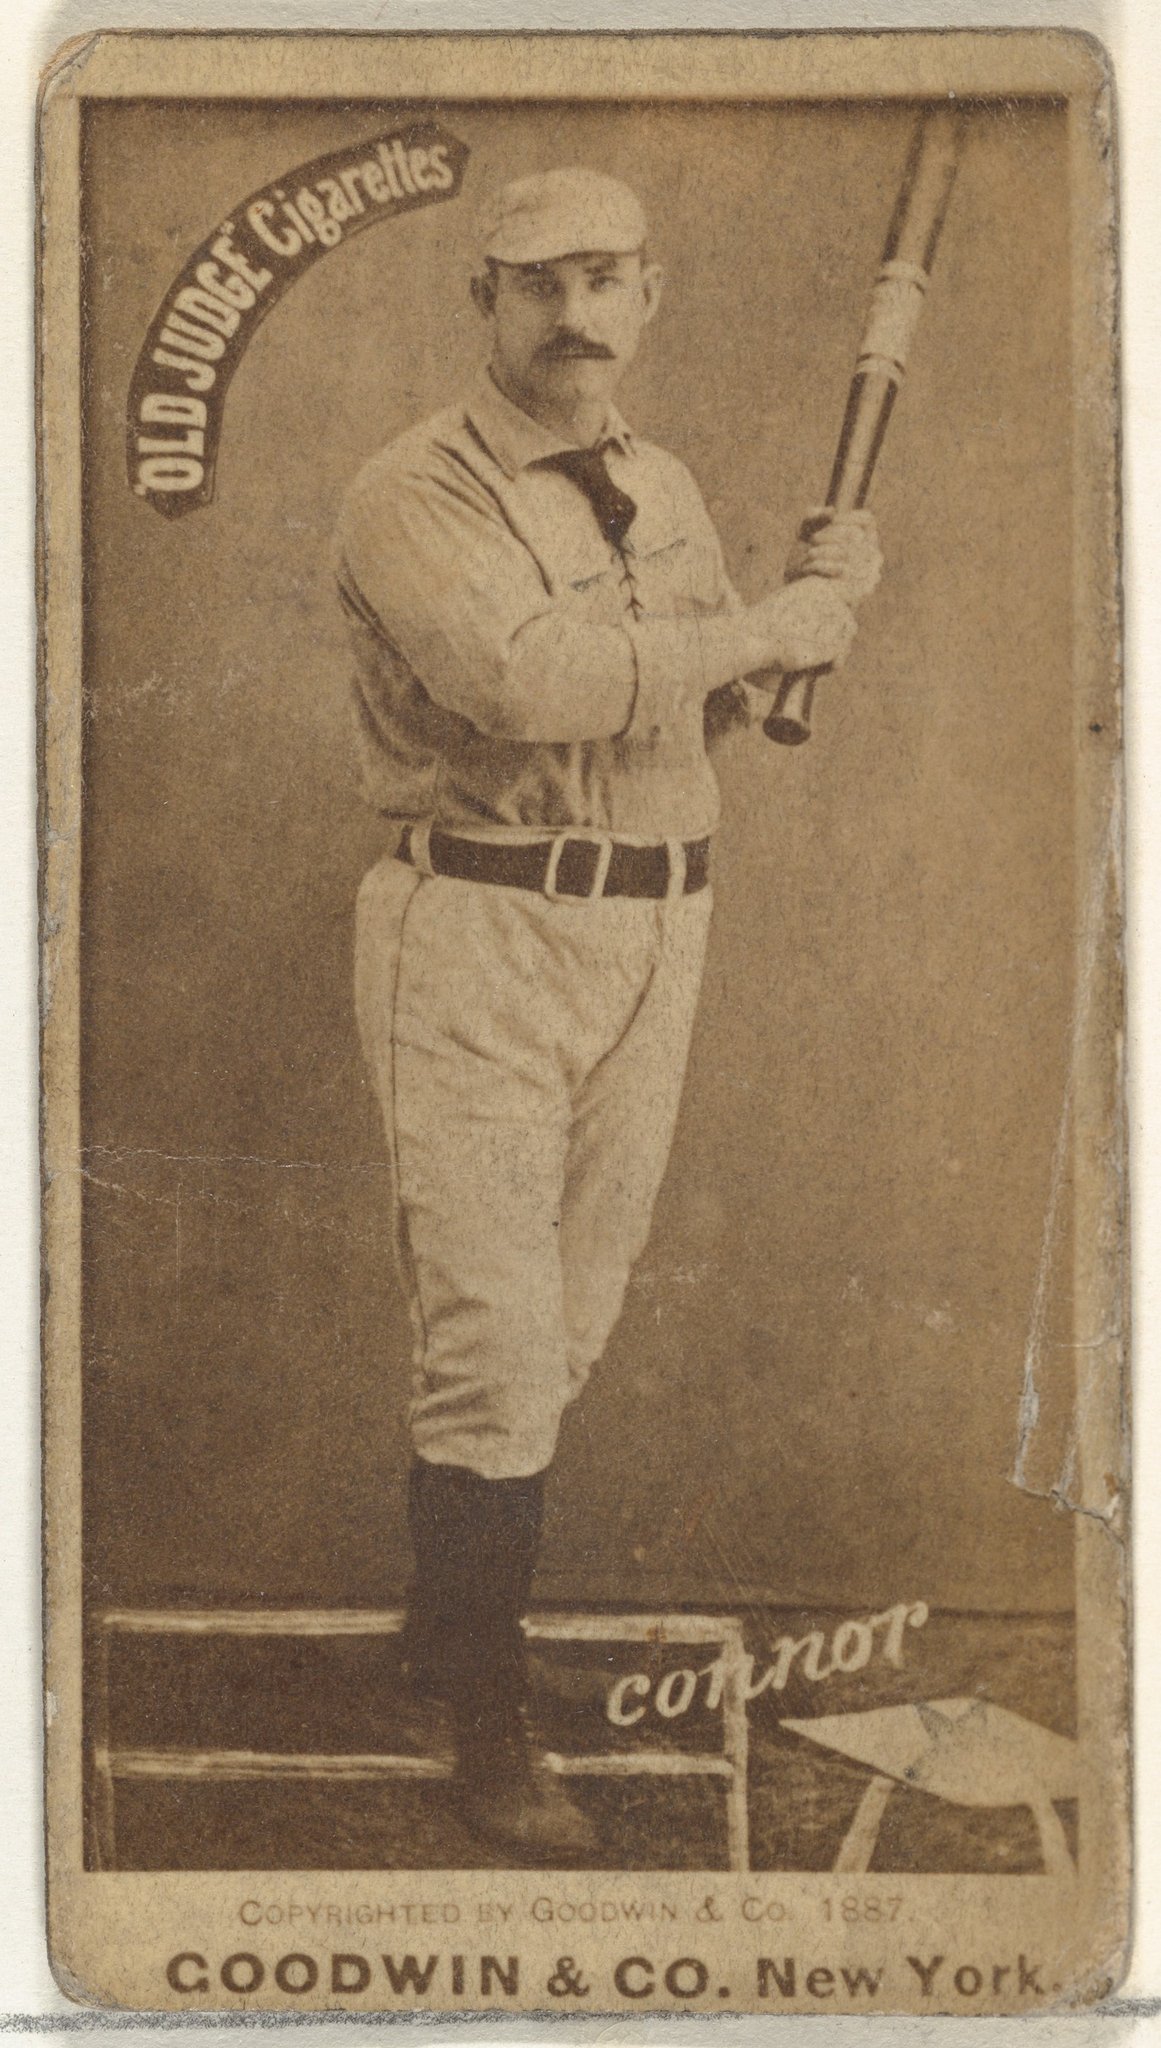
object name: baseball card, photograph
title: Roger Connor, New York Giants/Gothams, from the Old Judge series (N172) for Old Judge Cigarettes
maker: goodwin & company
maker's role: publisher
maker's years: 1850-1950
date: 1887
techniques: albumen silver print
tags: men,portraits,baseball,athletes